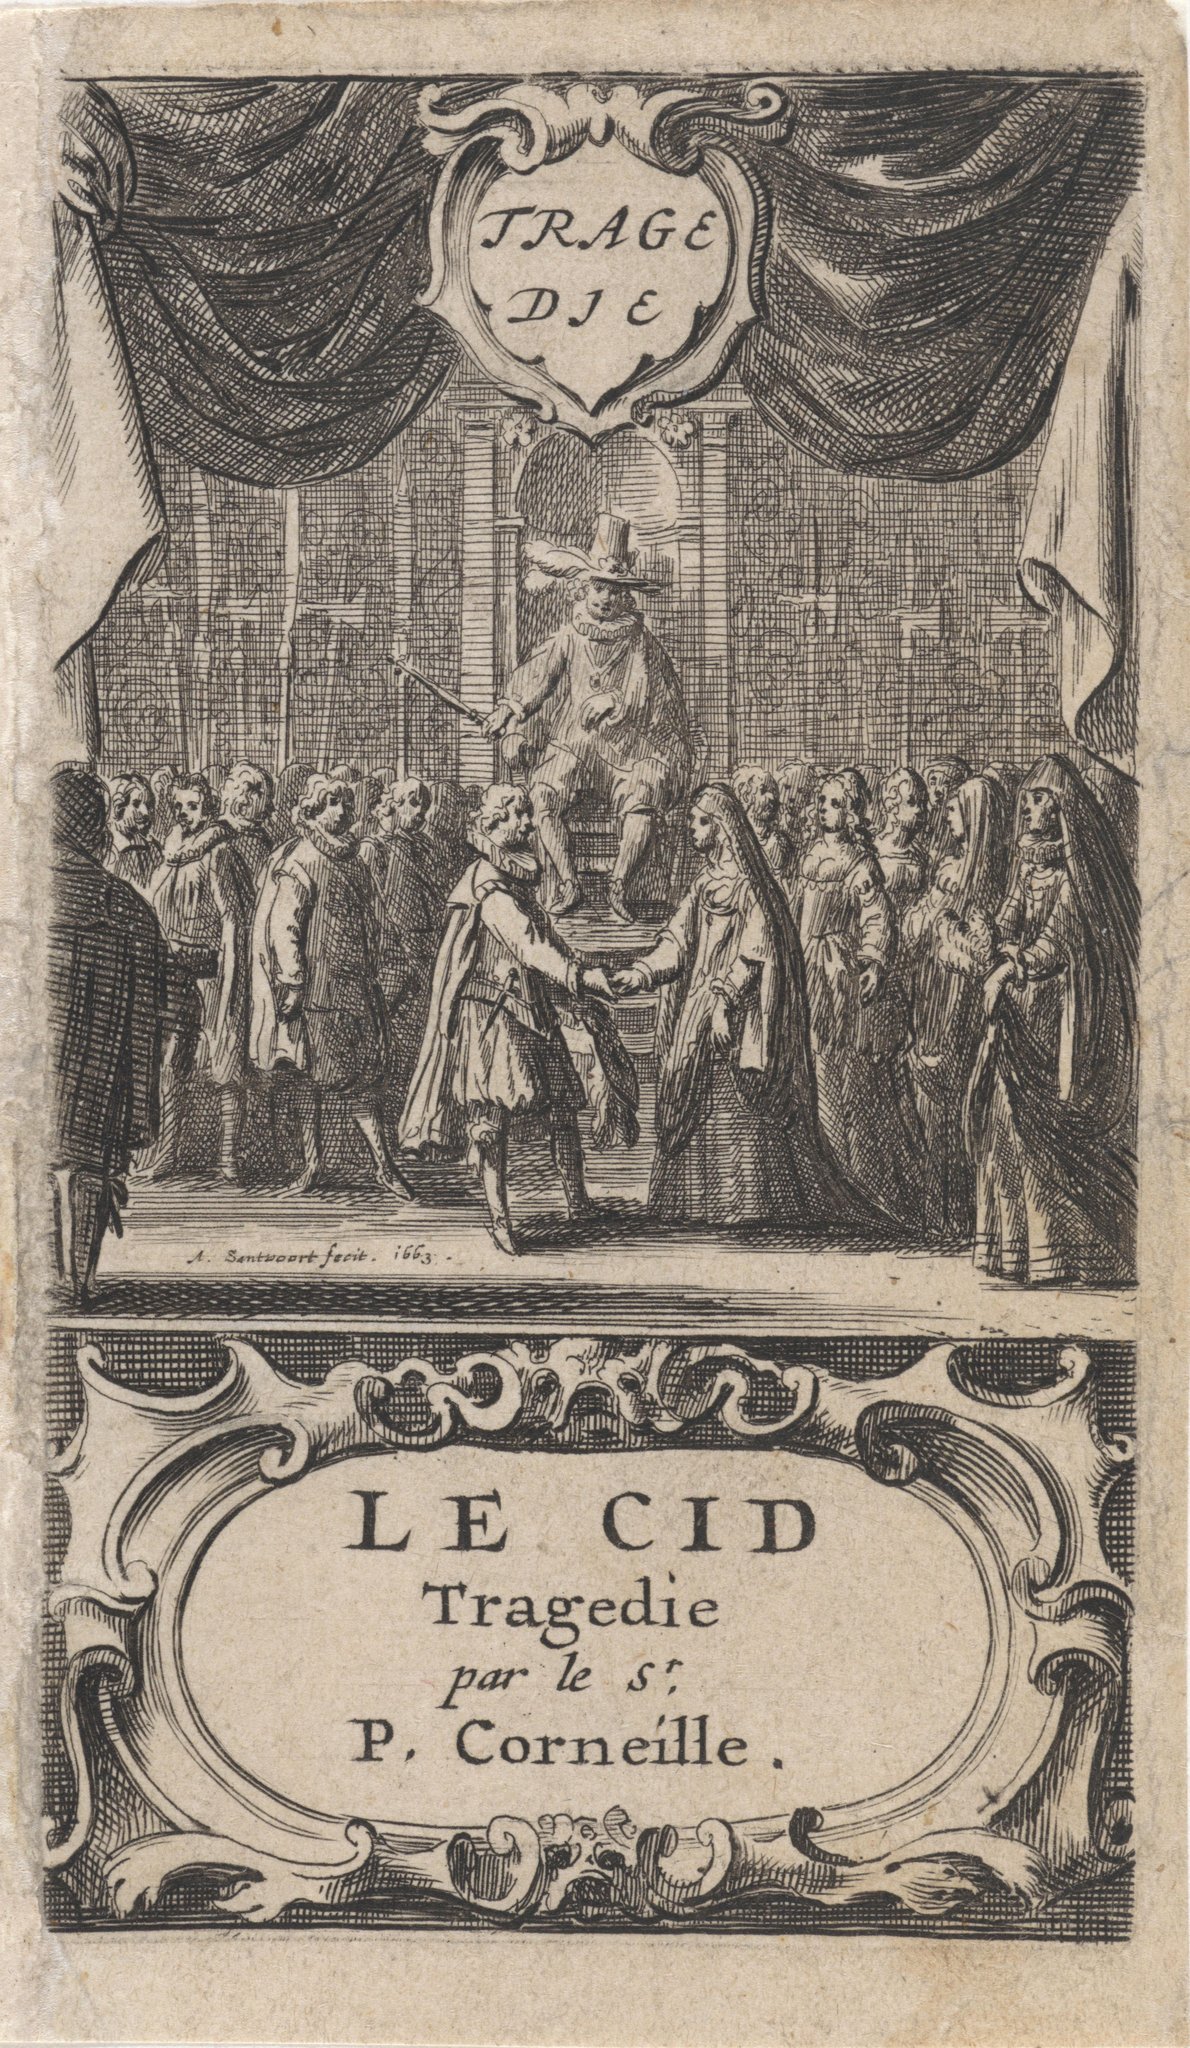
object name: titelblad, titelpagina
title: Alfons VI geeft El Cid Jimena als vrouw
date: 1663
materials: paper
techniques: etching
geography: amsterdam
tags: civil marriage ceremony, theatre, theatrical performance, title-page, throne-room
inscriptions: collector's mark: Lugt 2228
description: El Cid en Jimena staan hand in hand voor de tronende Alfons VI. Verschillende hovelingen kijken toe. Boven theatergordijnen. Onder een cartouche met de titel.